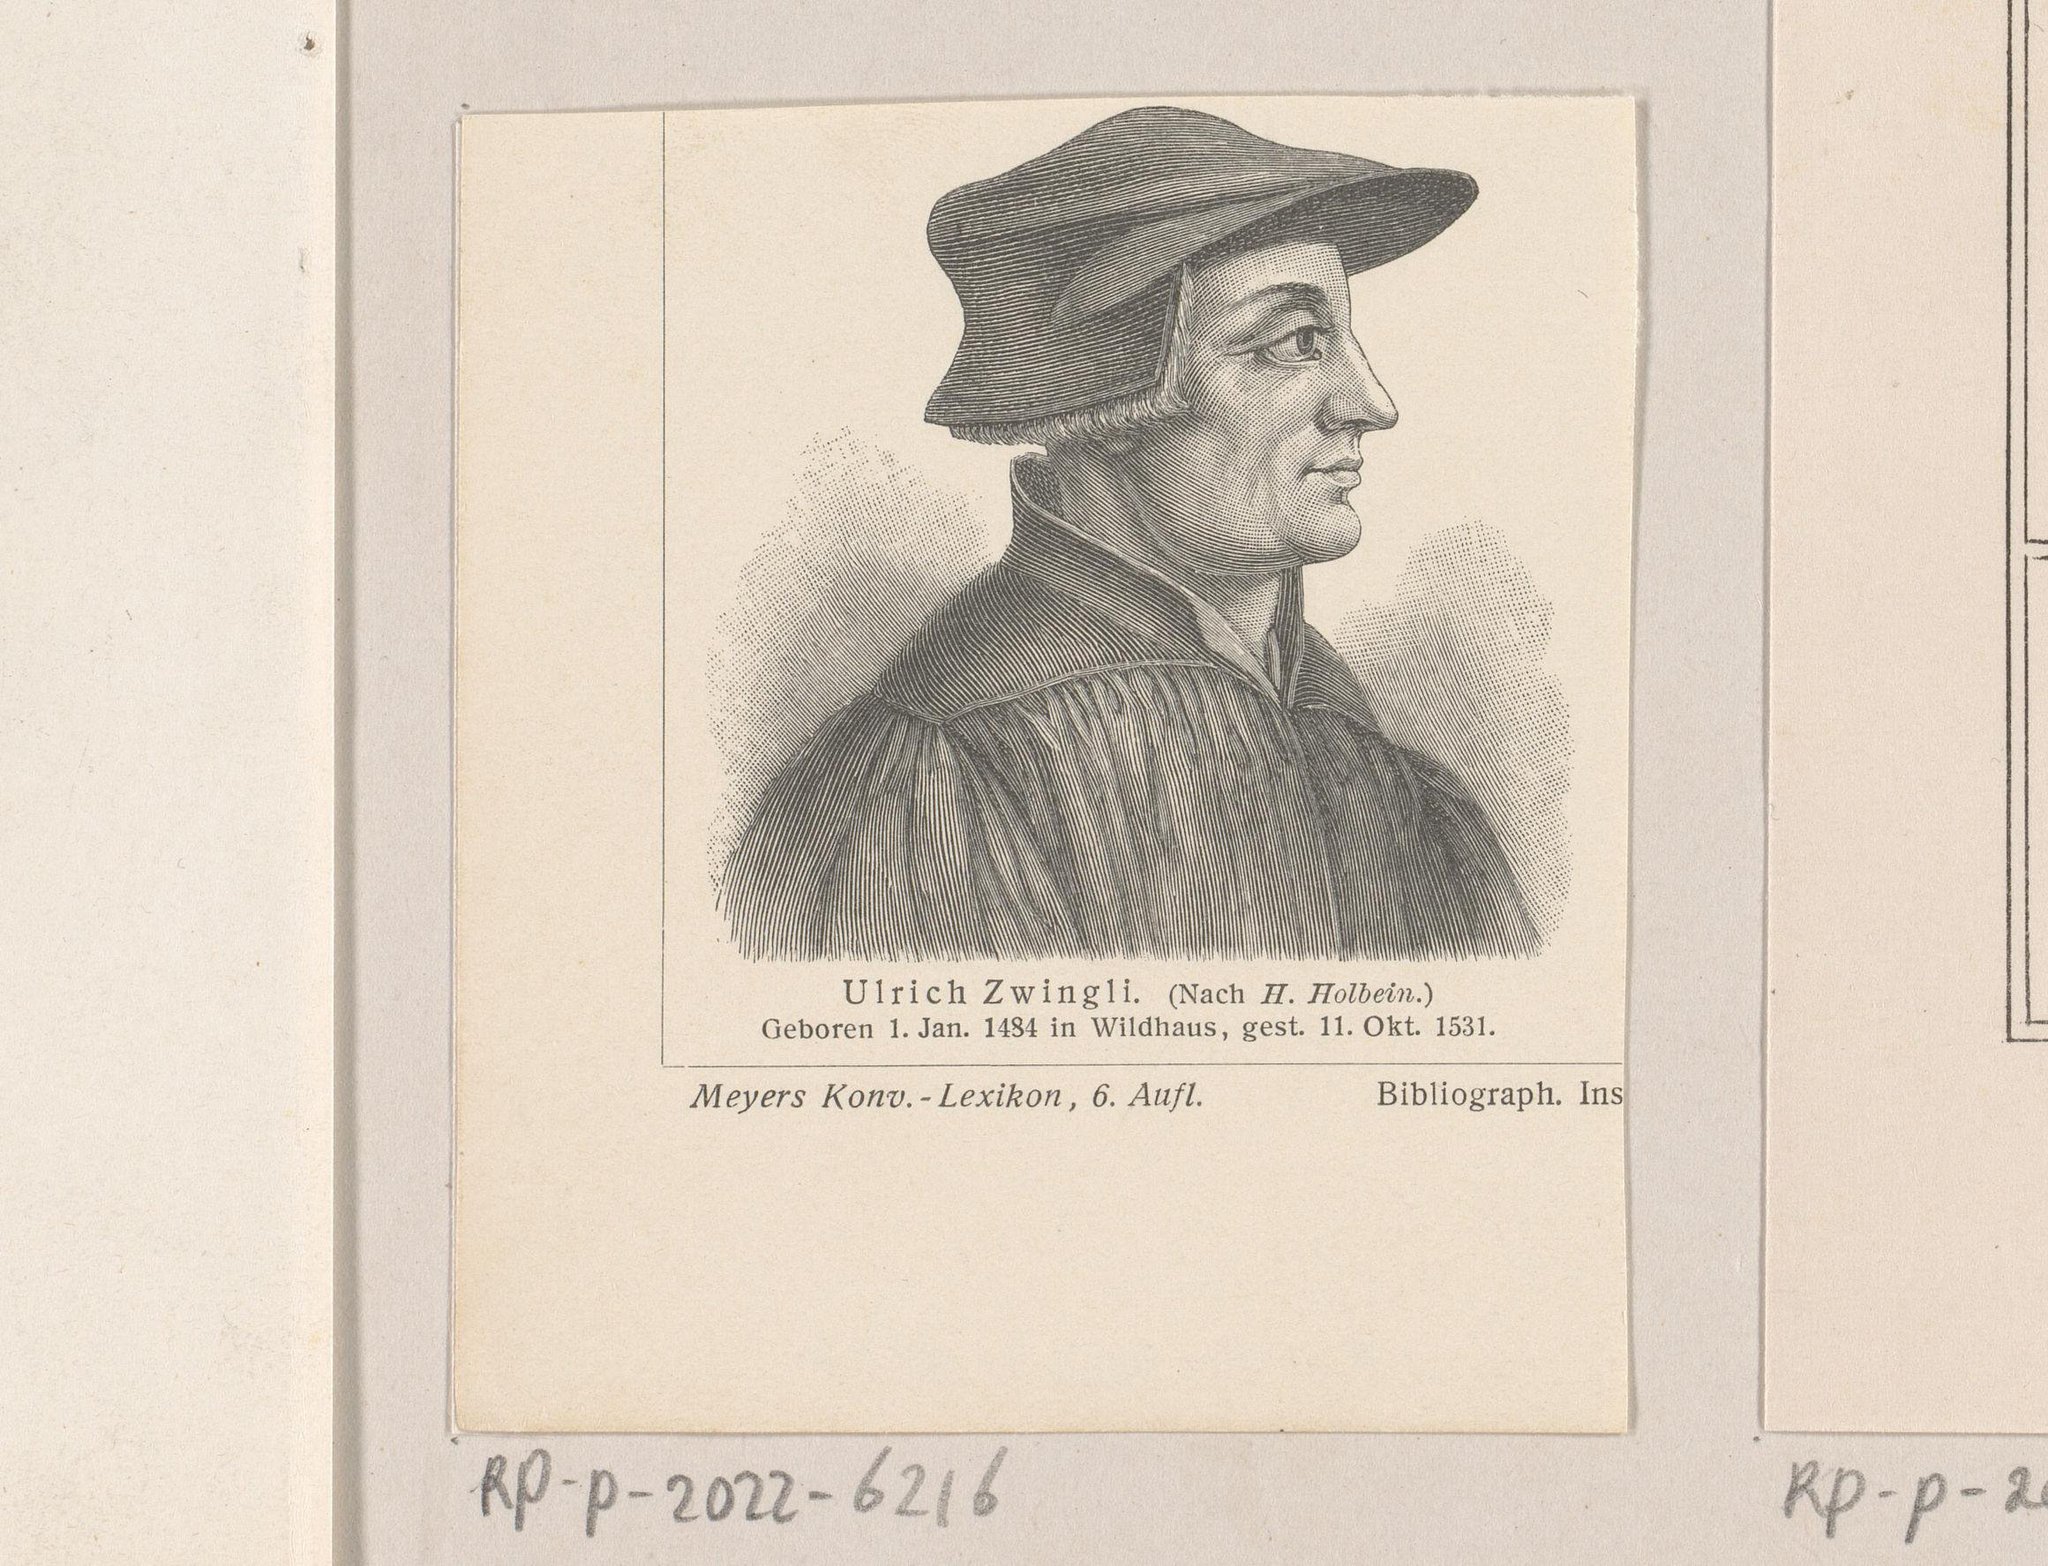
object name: print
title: Portret van Ulrich Zwingli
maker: Anonymous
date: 1902-1920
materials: paper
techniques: engraving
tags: theologian, historical persons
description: Prent waarschijnlijk uit één van de delen van: Meyer, Joseph. Meyers Großes Konversations-Lexikon. Ein Nachschlagewerk des allgemeinen Wissens. S.l.: Bibliographischen Instituts, 1902-1920, 6e druk.